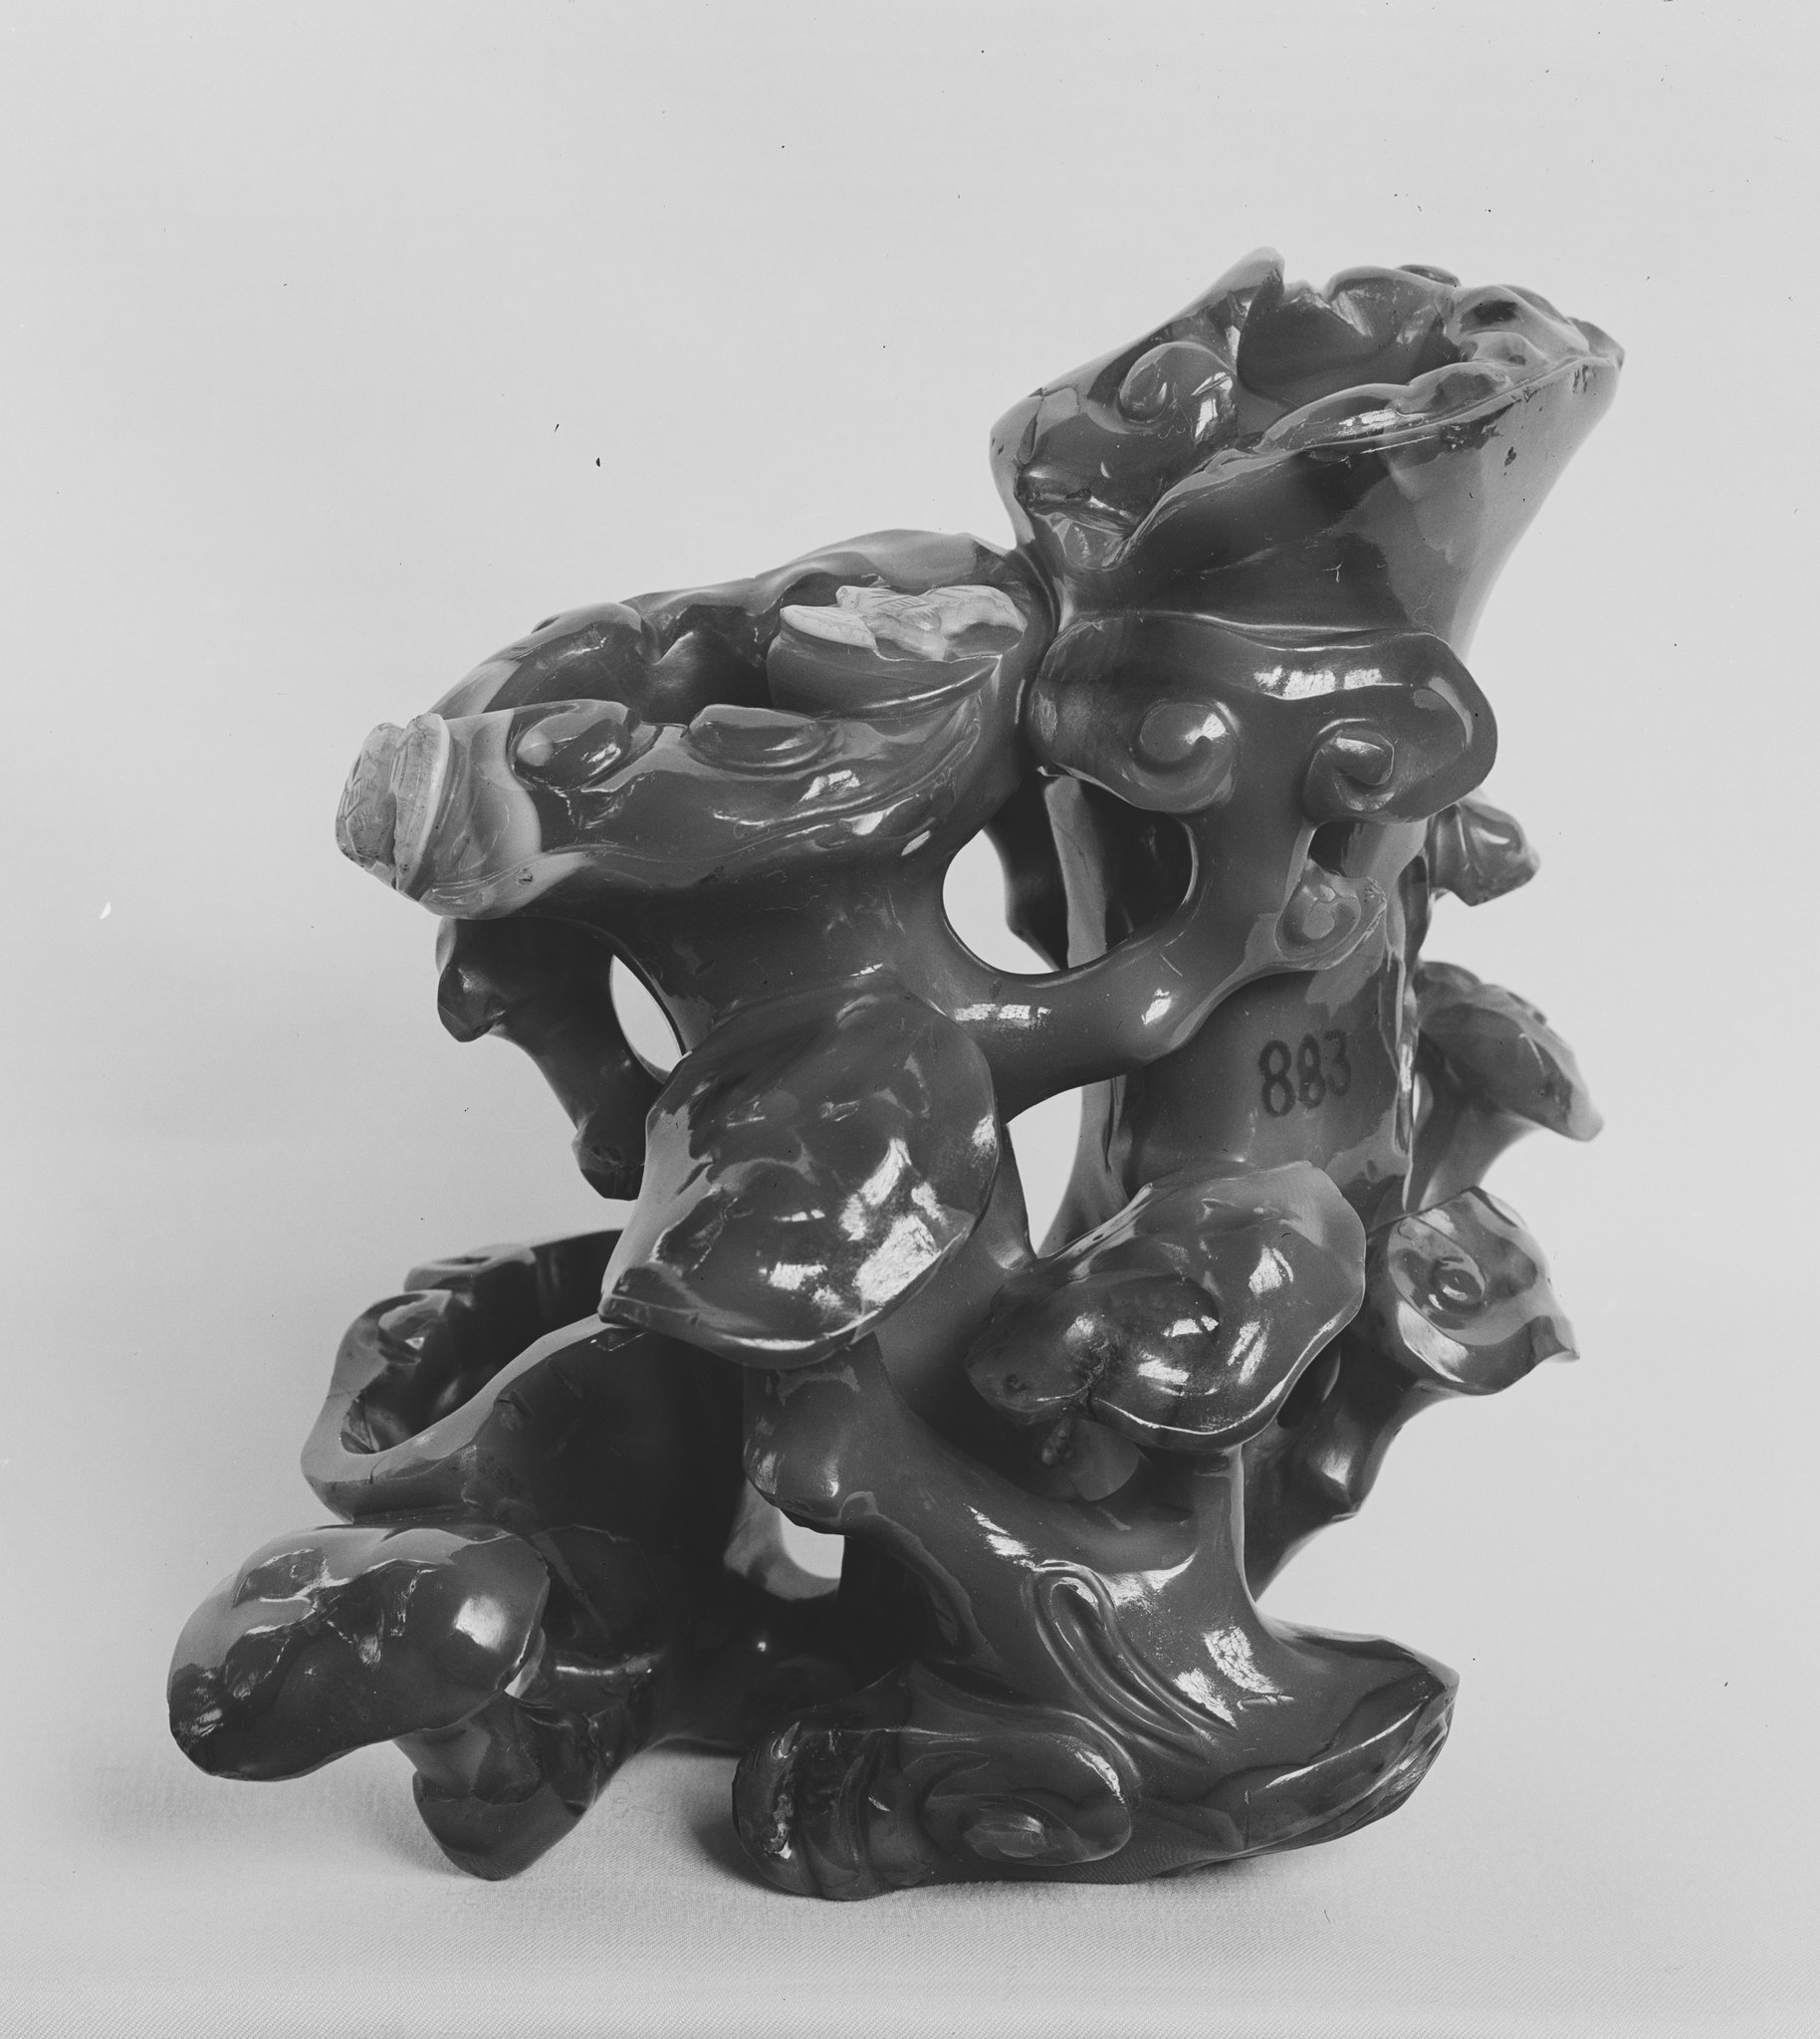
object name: double vase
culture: chinese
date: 1701-1800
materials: stone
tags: leaves